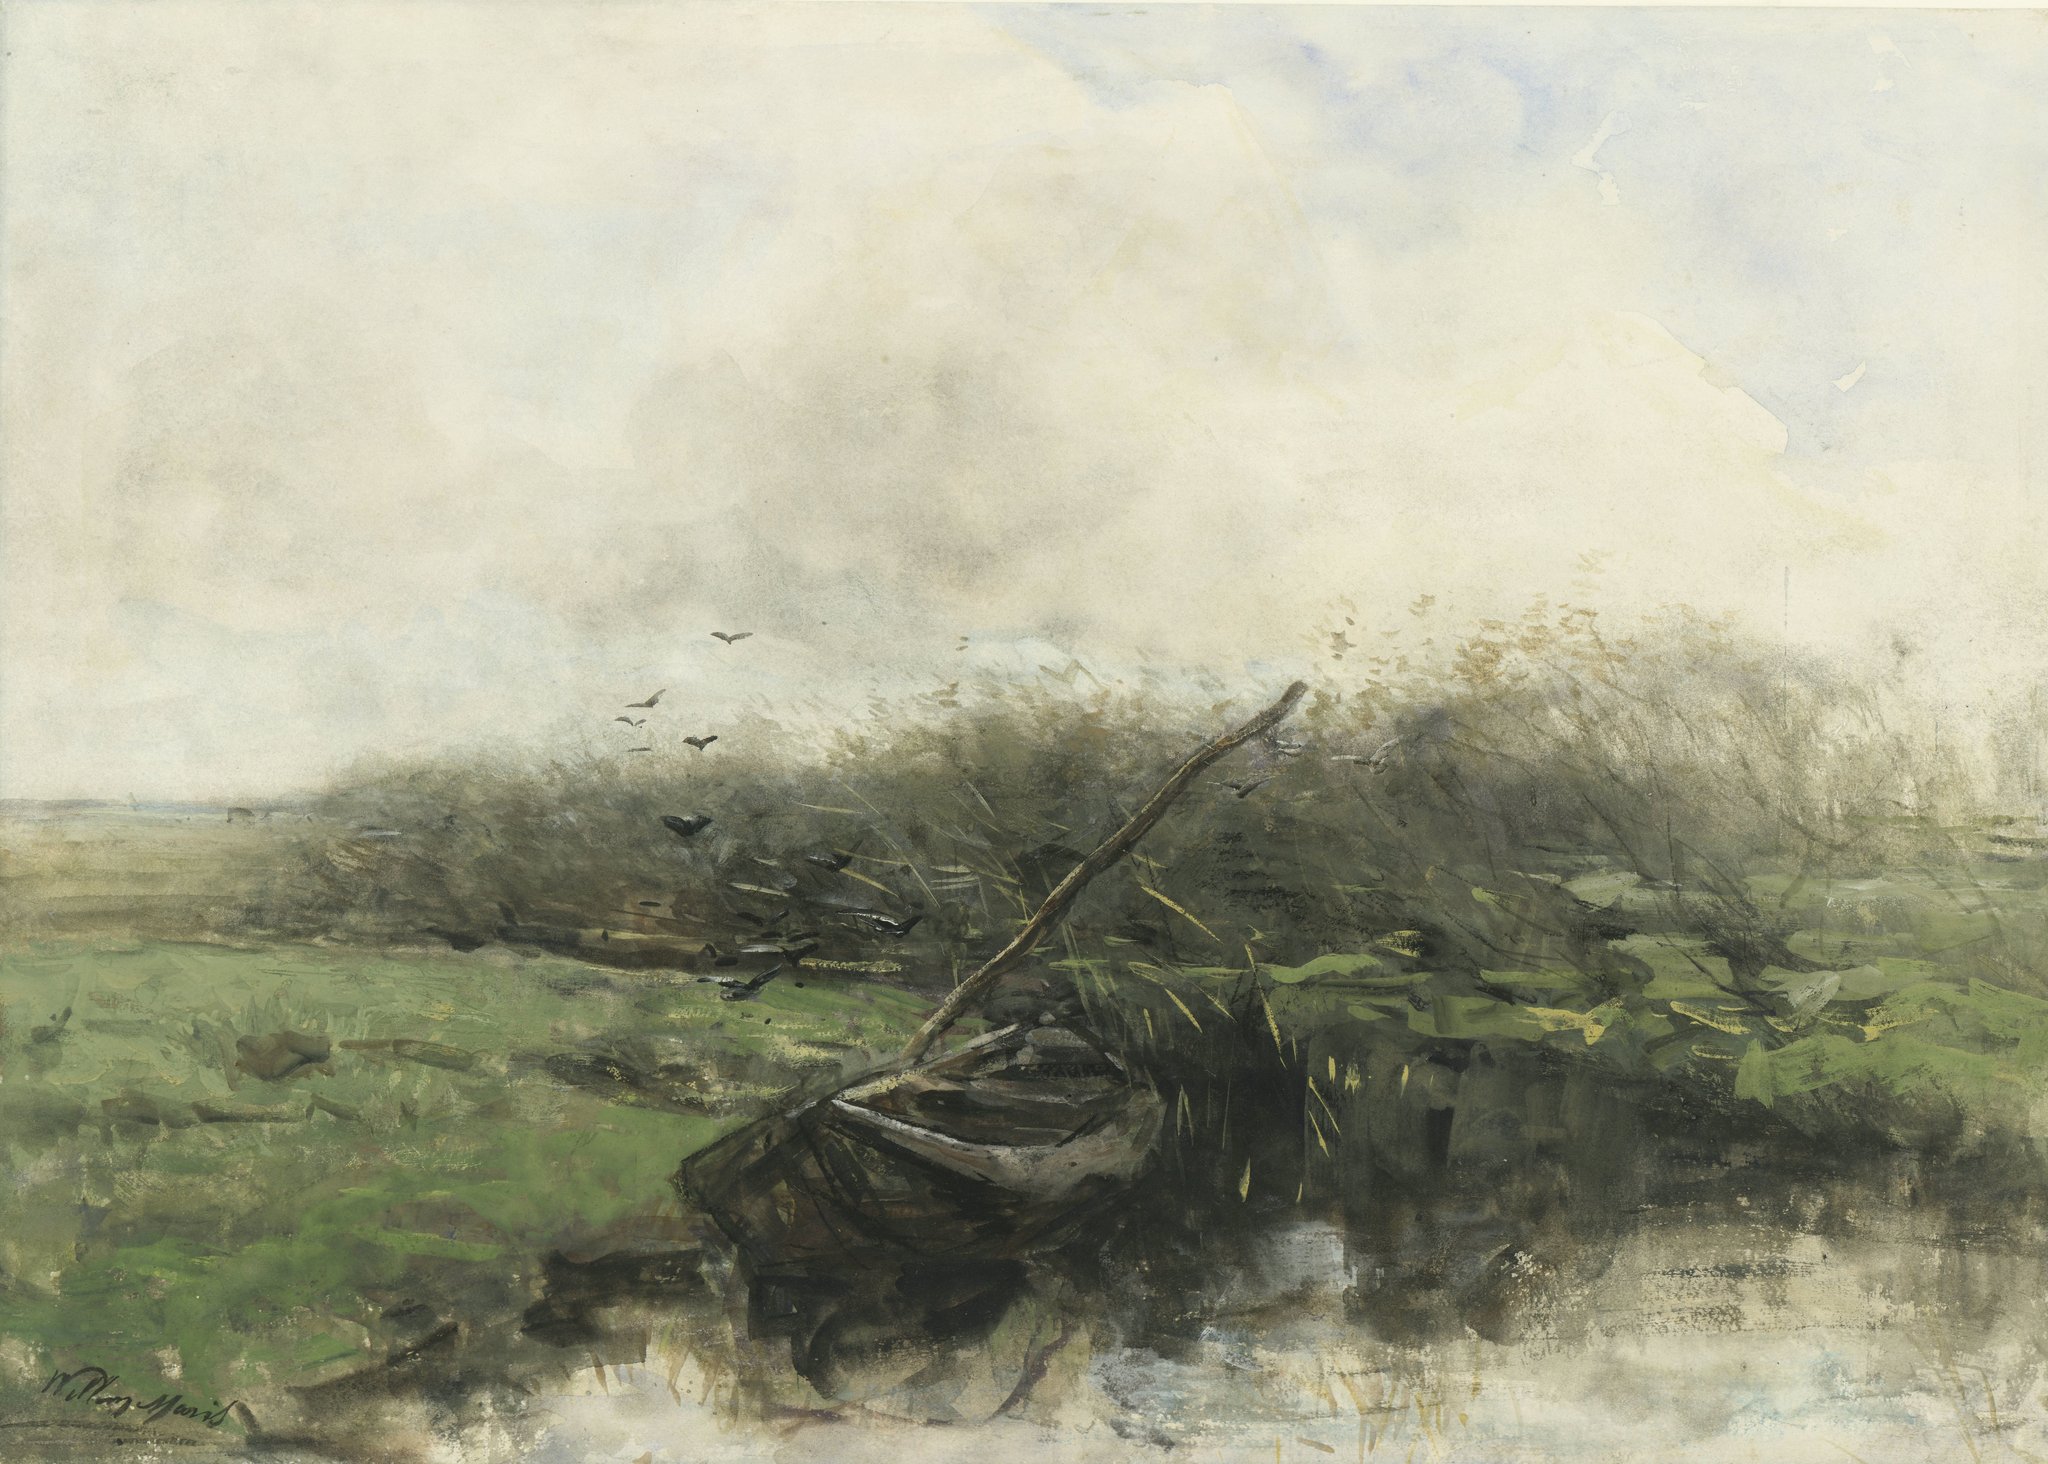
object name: drawing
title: Roeiboot in een sloot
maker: willem maris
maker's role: draughtsman, painter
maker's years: 1844-1910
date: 1854-1910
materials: paper, watercolor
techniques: brush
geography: netherlands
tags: rowing-boat, canoe, etc.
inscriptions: signature: ‘Willem Maris’